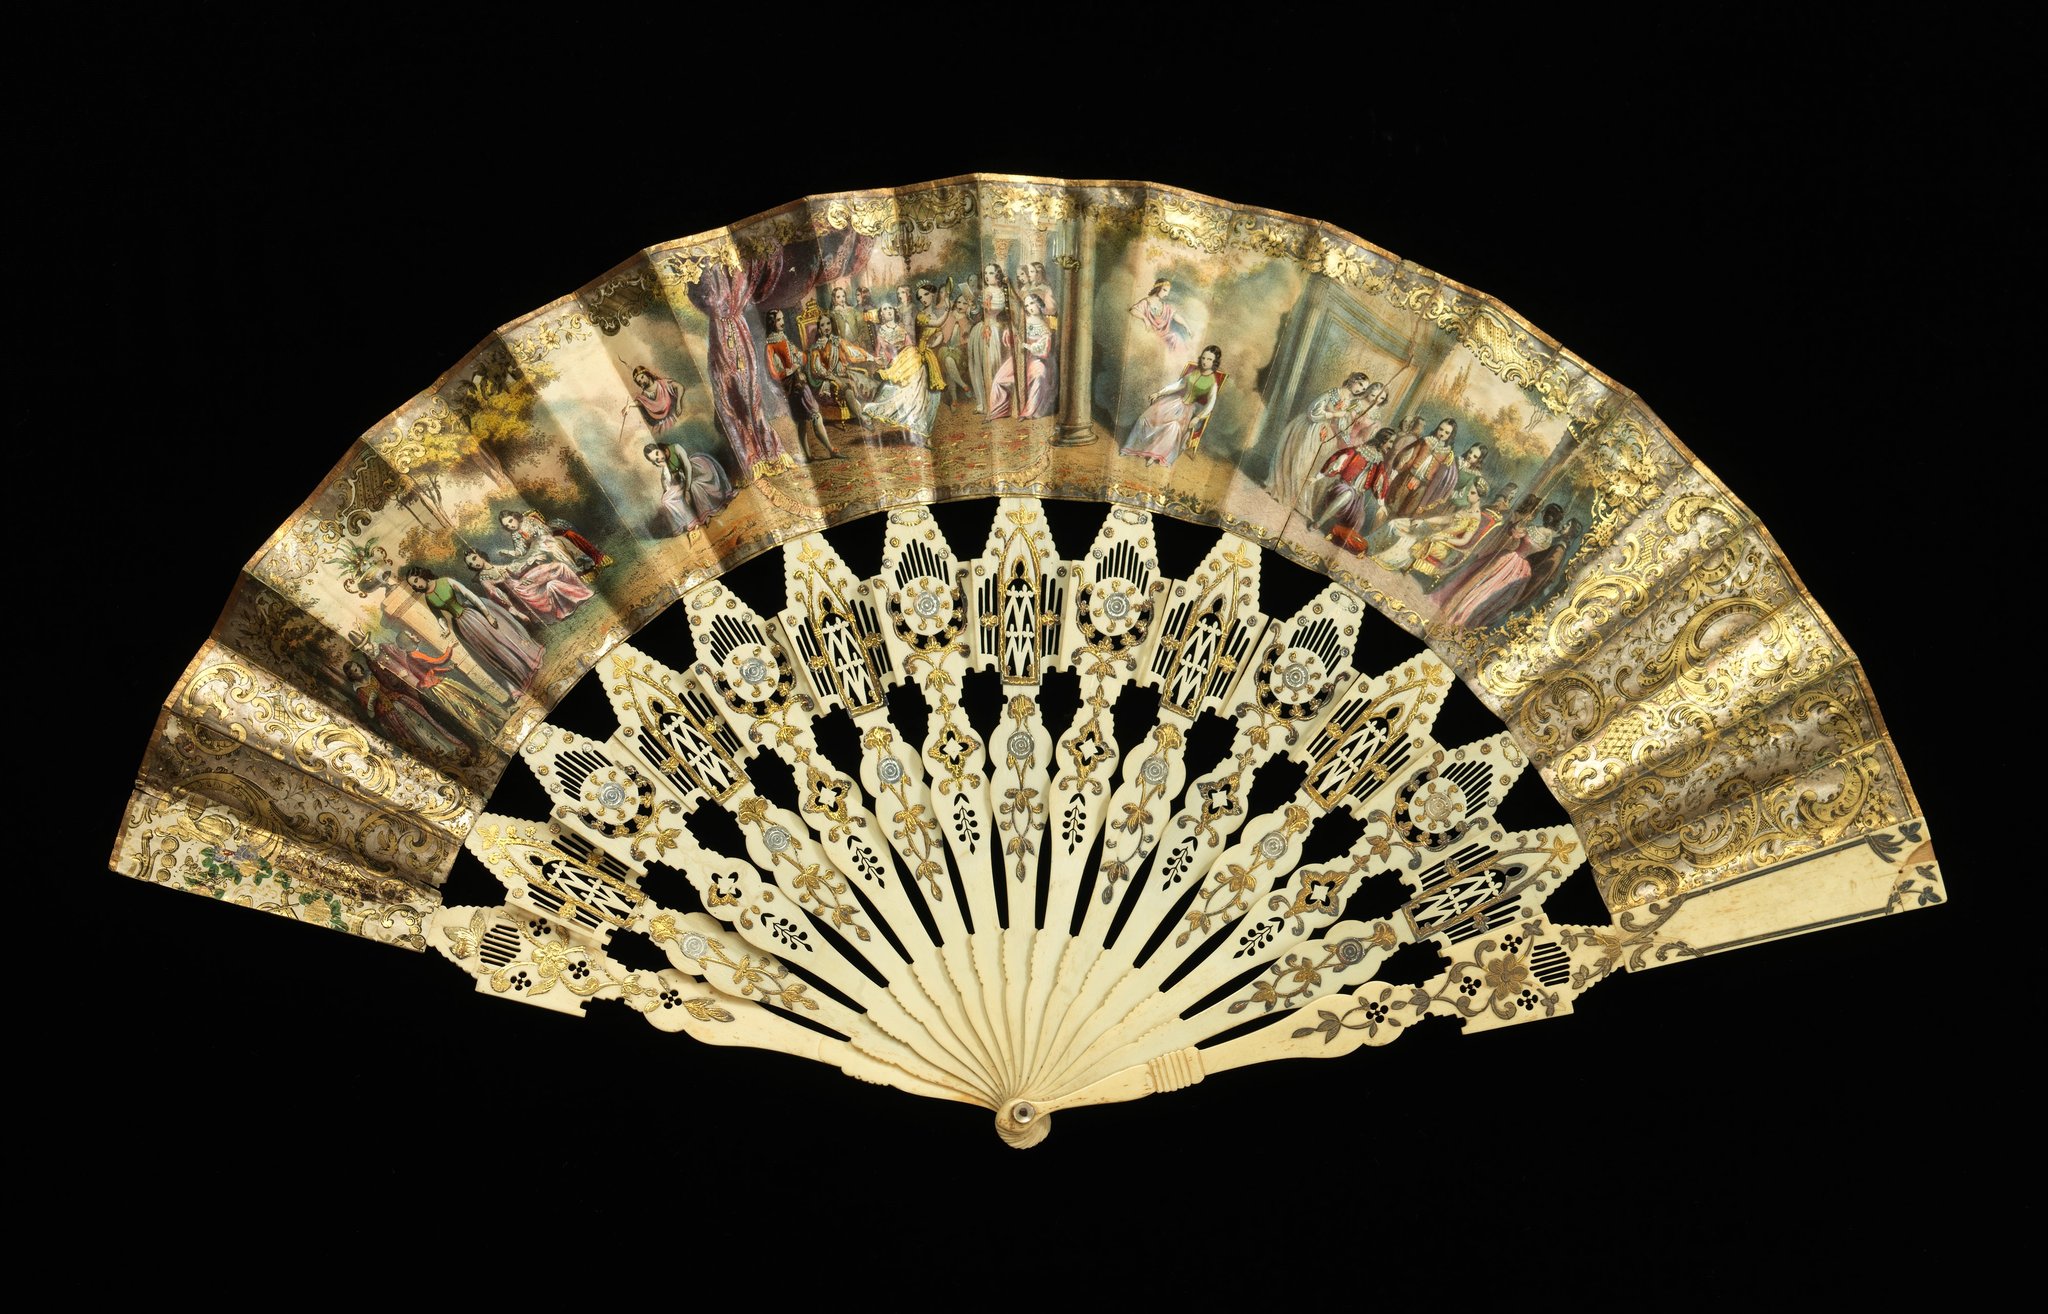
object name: fan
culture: spanish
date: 1860-1869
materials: ivory, metal, mother of pearl, paper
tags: men,women